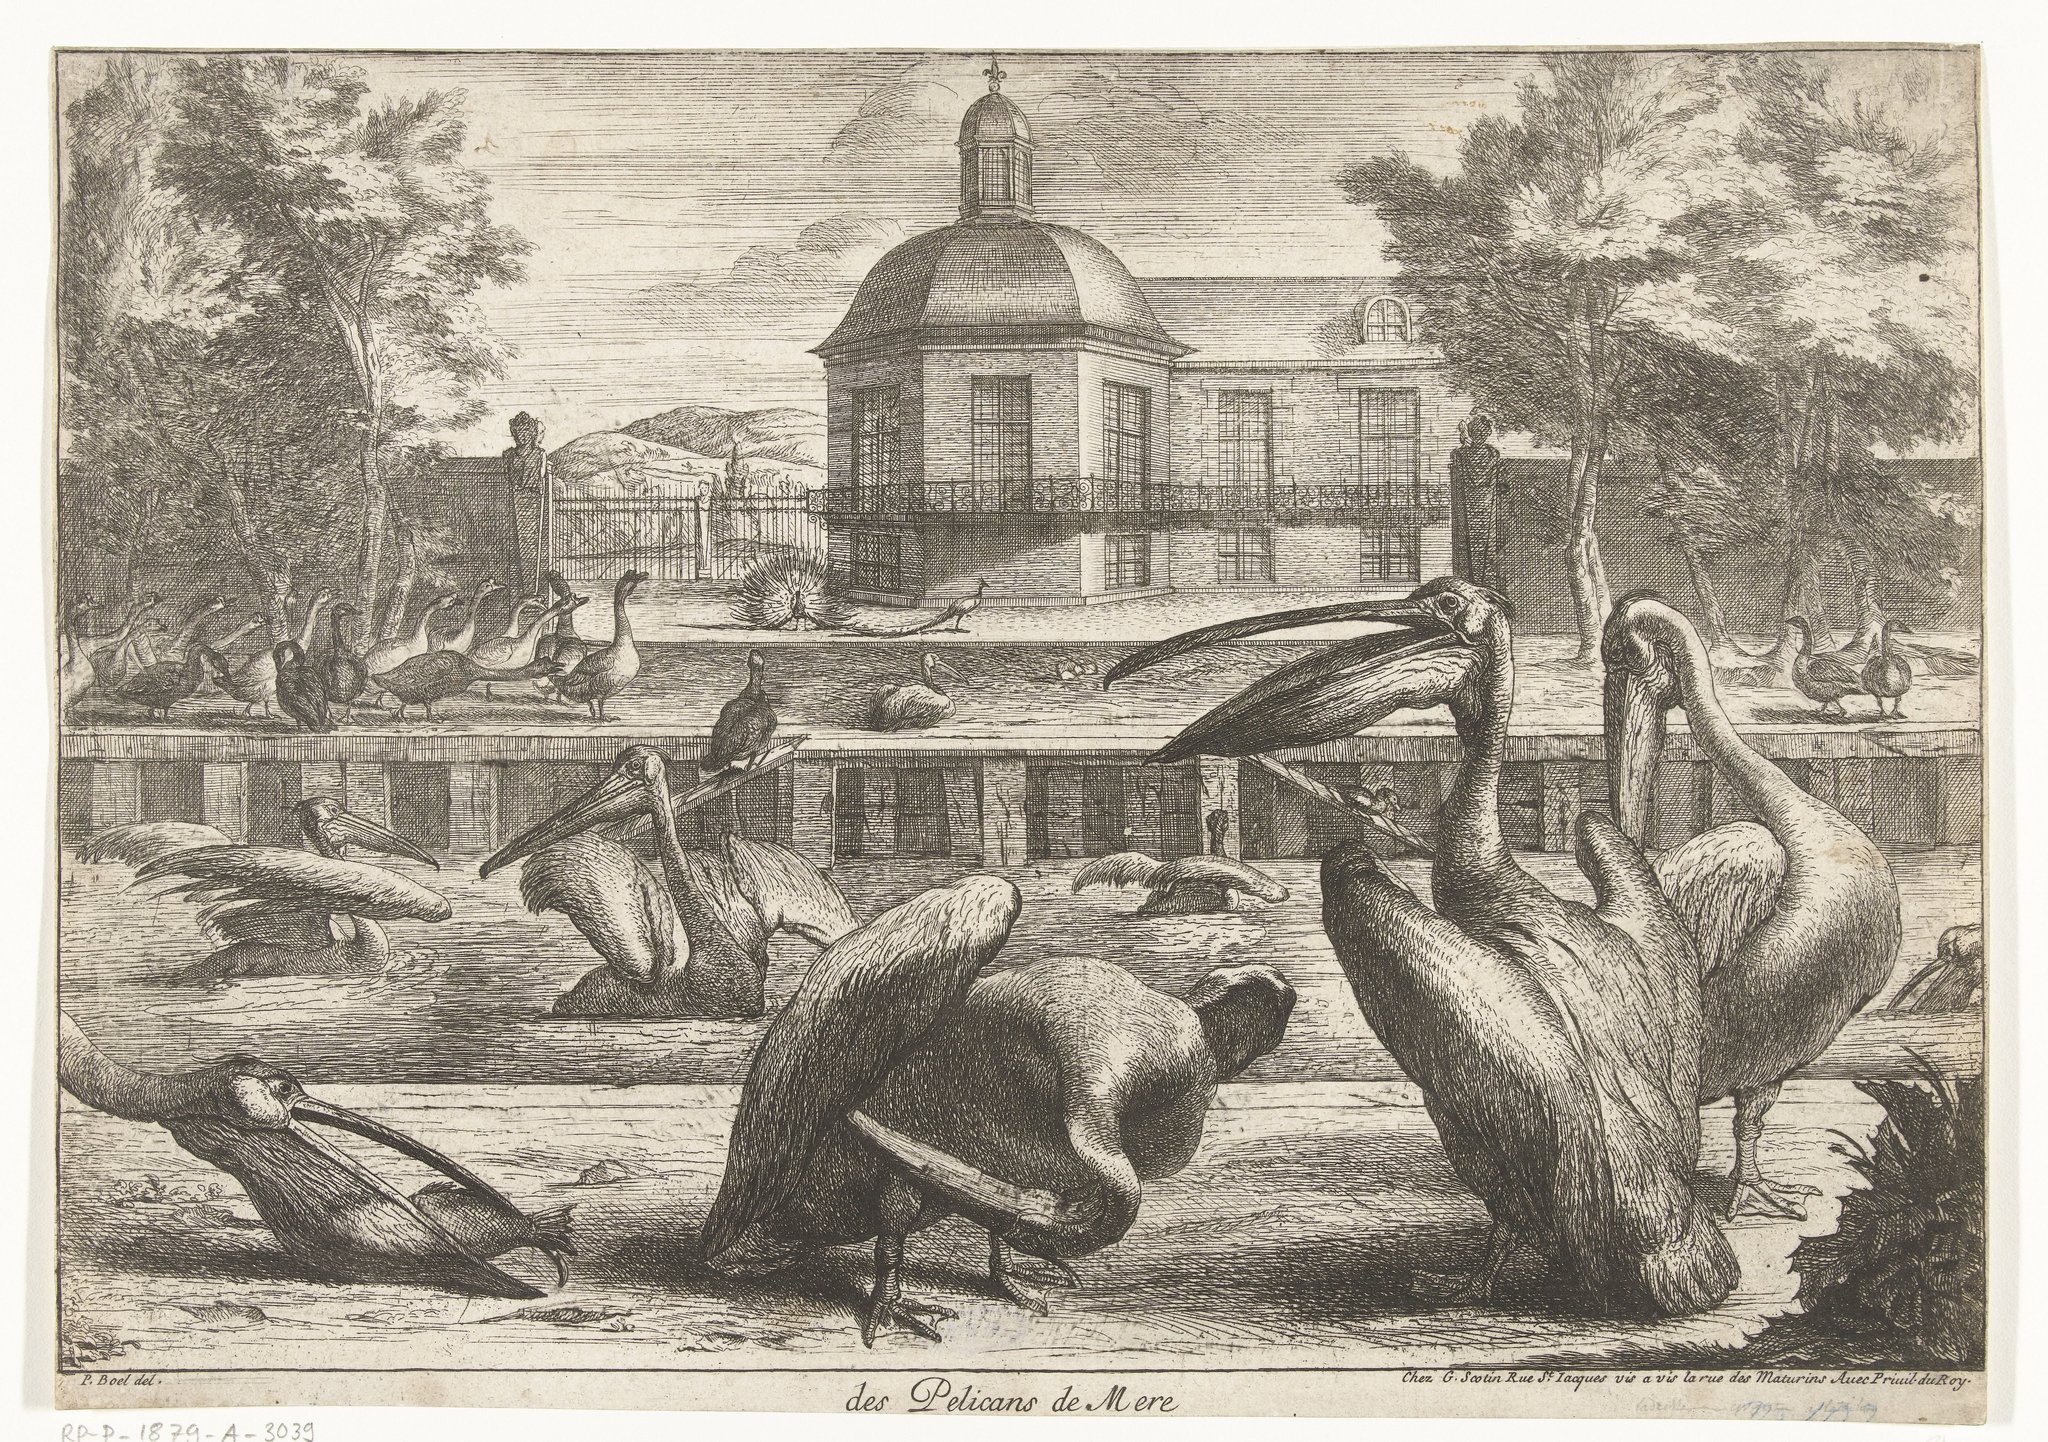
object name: print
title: Vogels uit de menagerie van Versailles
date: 1670-1674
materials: paper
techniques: etching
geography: paris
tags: water-birds: pelican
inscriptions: collector's mark: Lugt 2228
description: Pelikanen zwemmen in een gracht in de menagerie van Versailles. Op de achtergrond zijn ganzen en pauwen te zien.